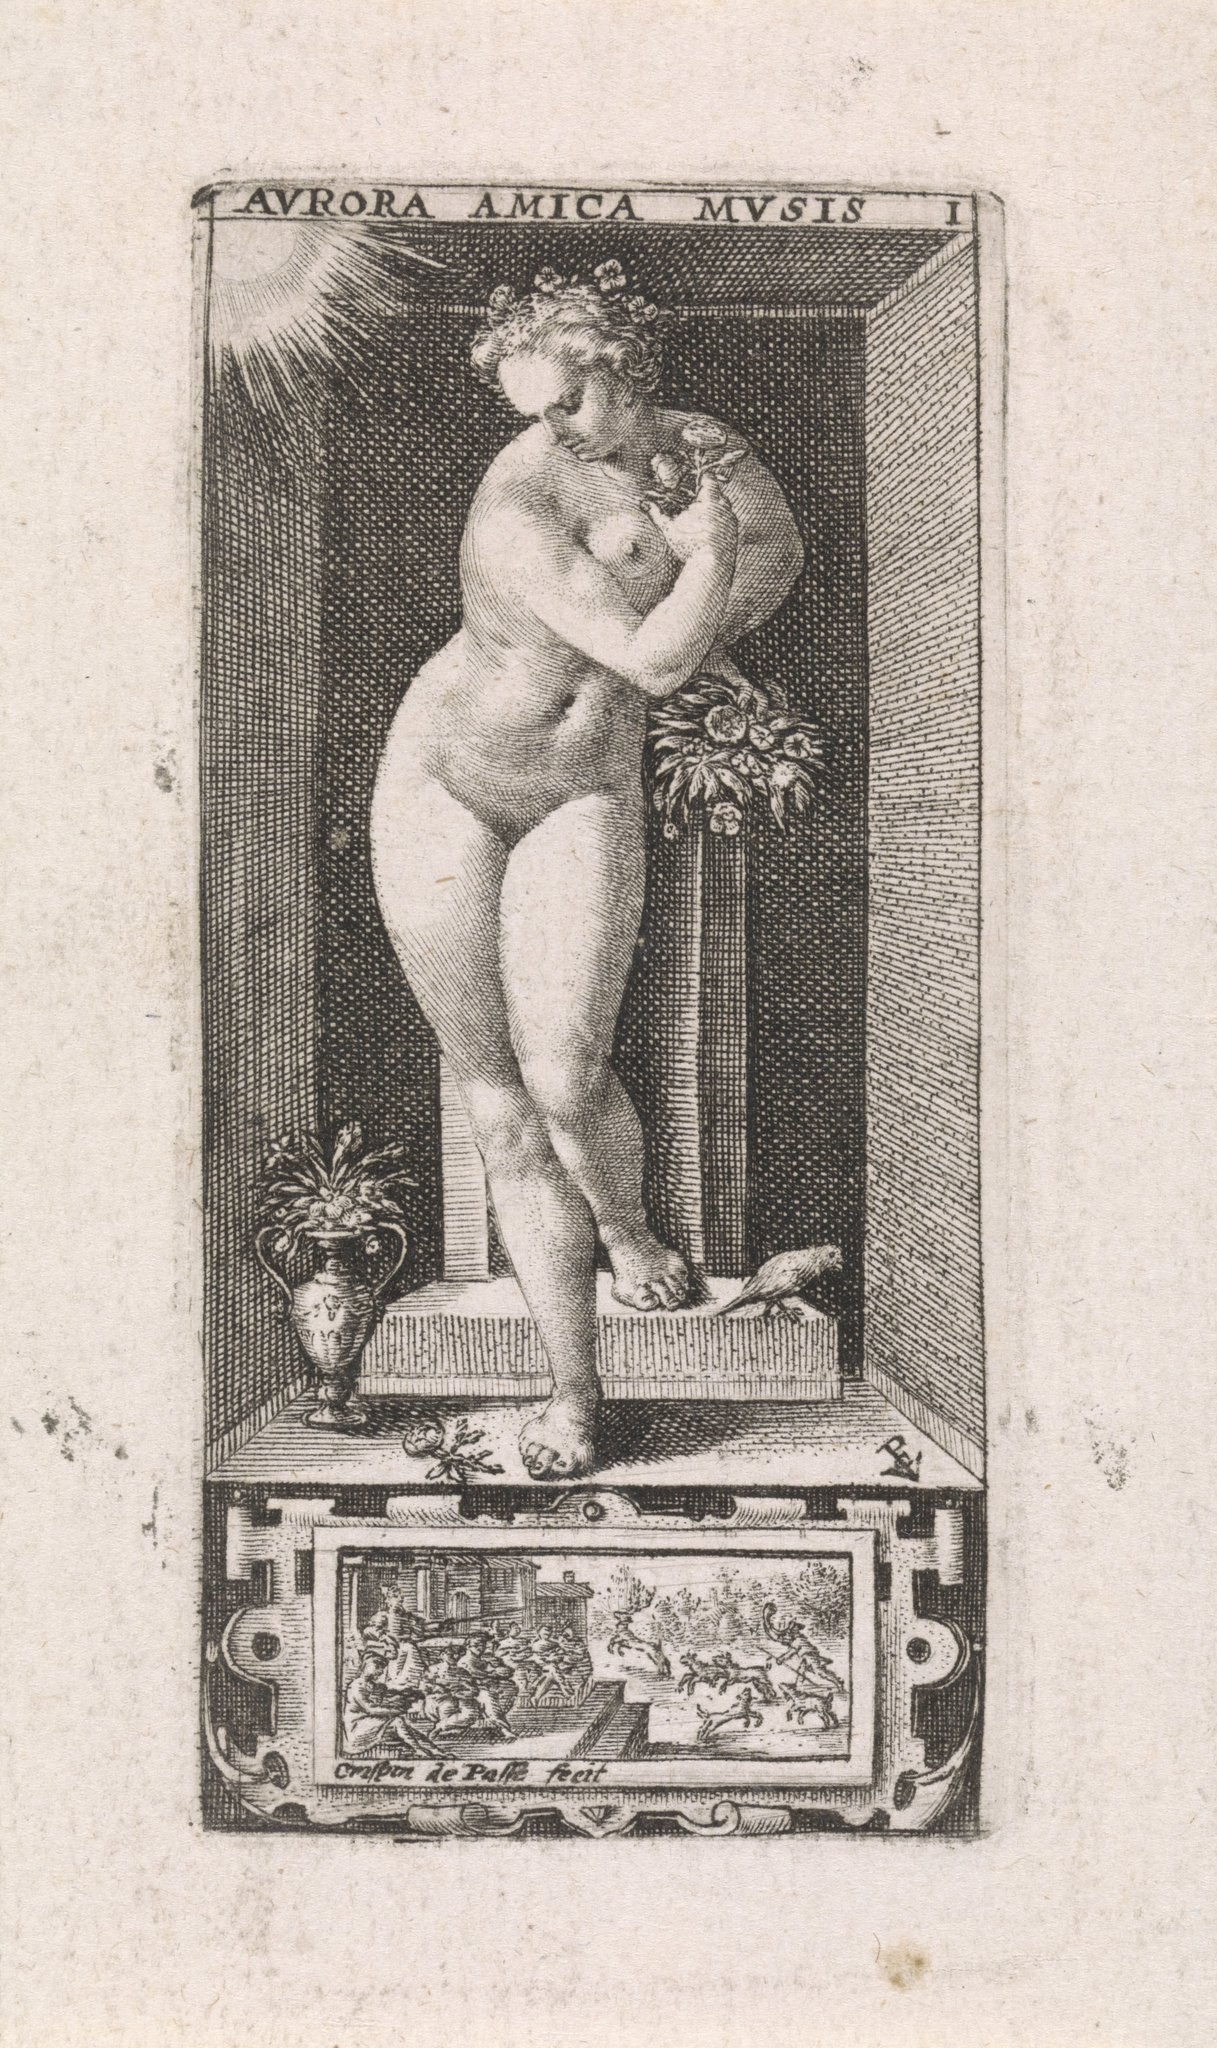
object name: print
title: Avrora Amica Mvsis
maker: crispijn van de passe (i)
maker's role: draughtsman, print maker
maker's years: 1564-1637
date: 1574-1637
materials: paper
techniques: engraving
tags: hunting, chase, ornamental birds: parrot, personification of the morning, 'aurora'; 'aurora' (ripa)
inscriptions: collector's mark: Lugt 964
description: Nis met Aurora, de godin van het ochtendgloren, als vrouwelijke personificatie van de Ochtend. Ze wordt vergezeld door een papegaai. In de cartouche onder de nis een hertenjacht.